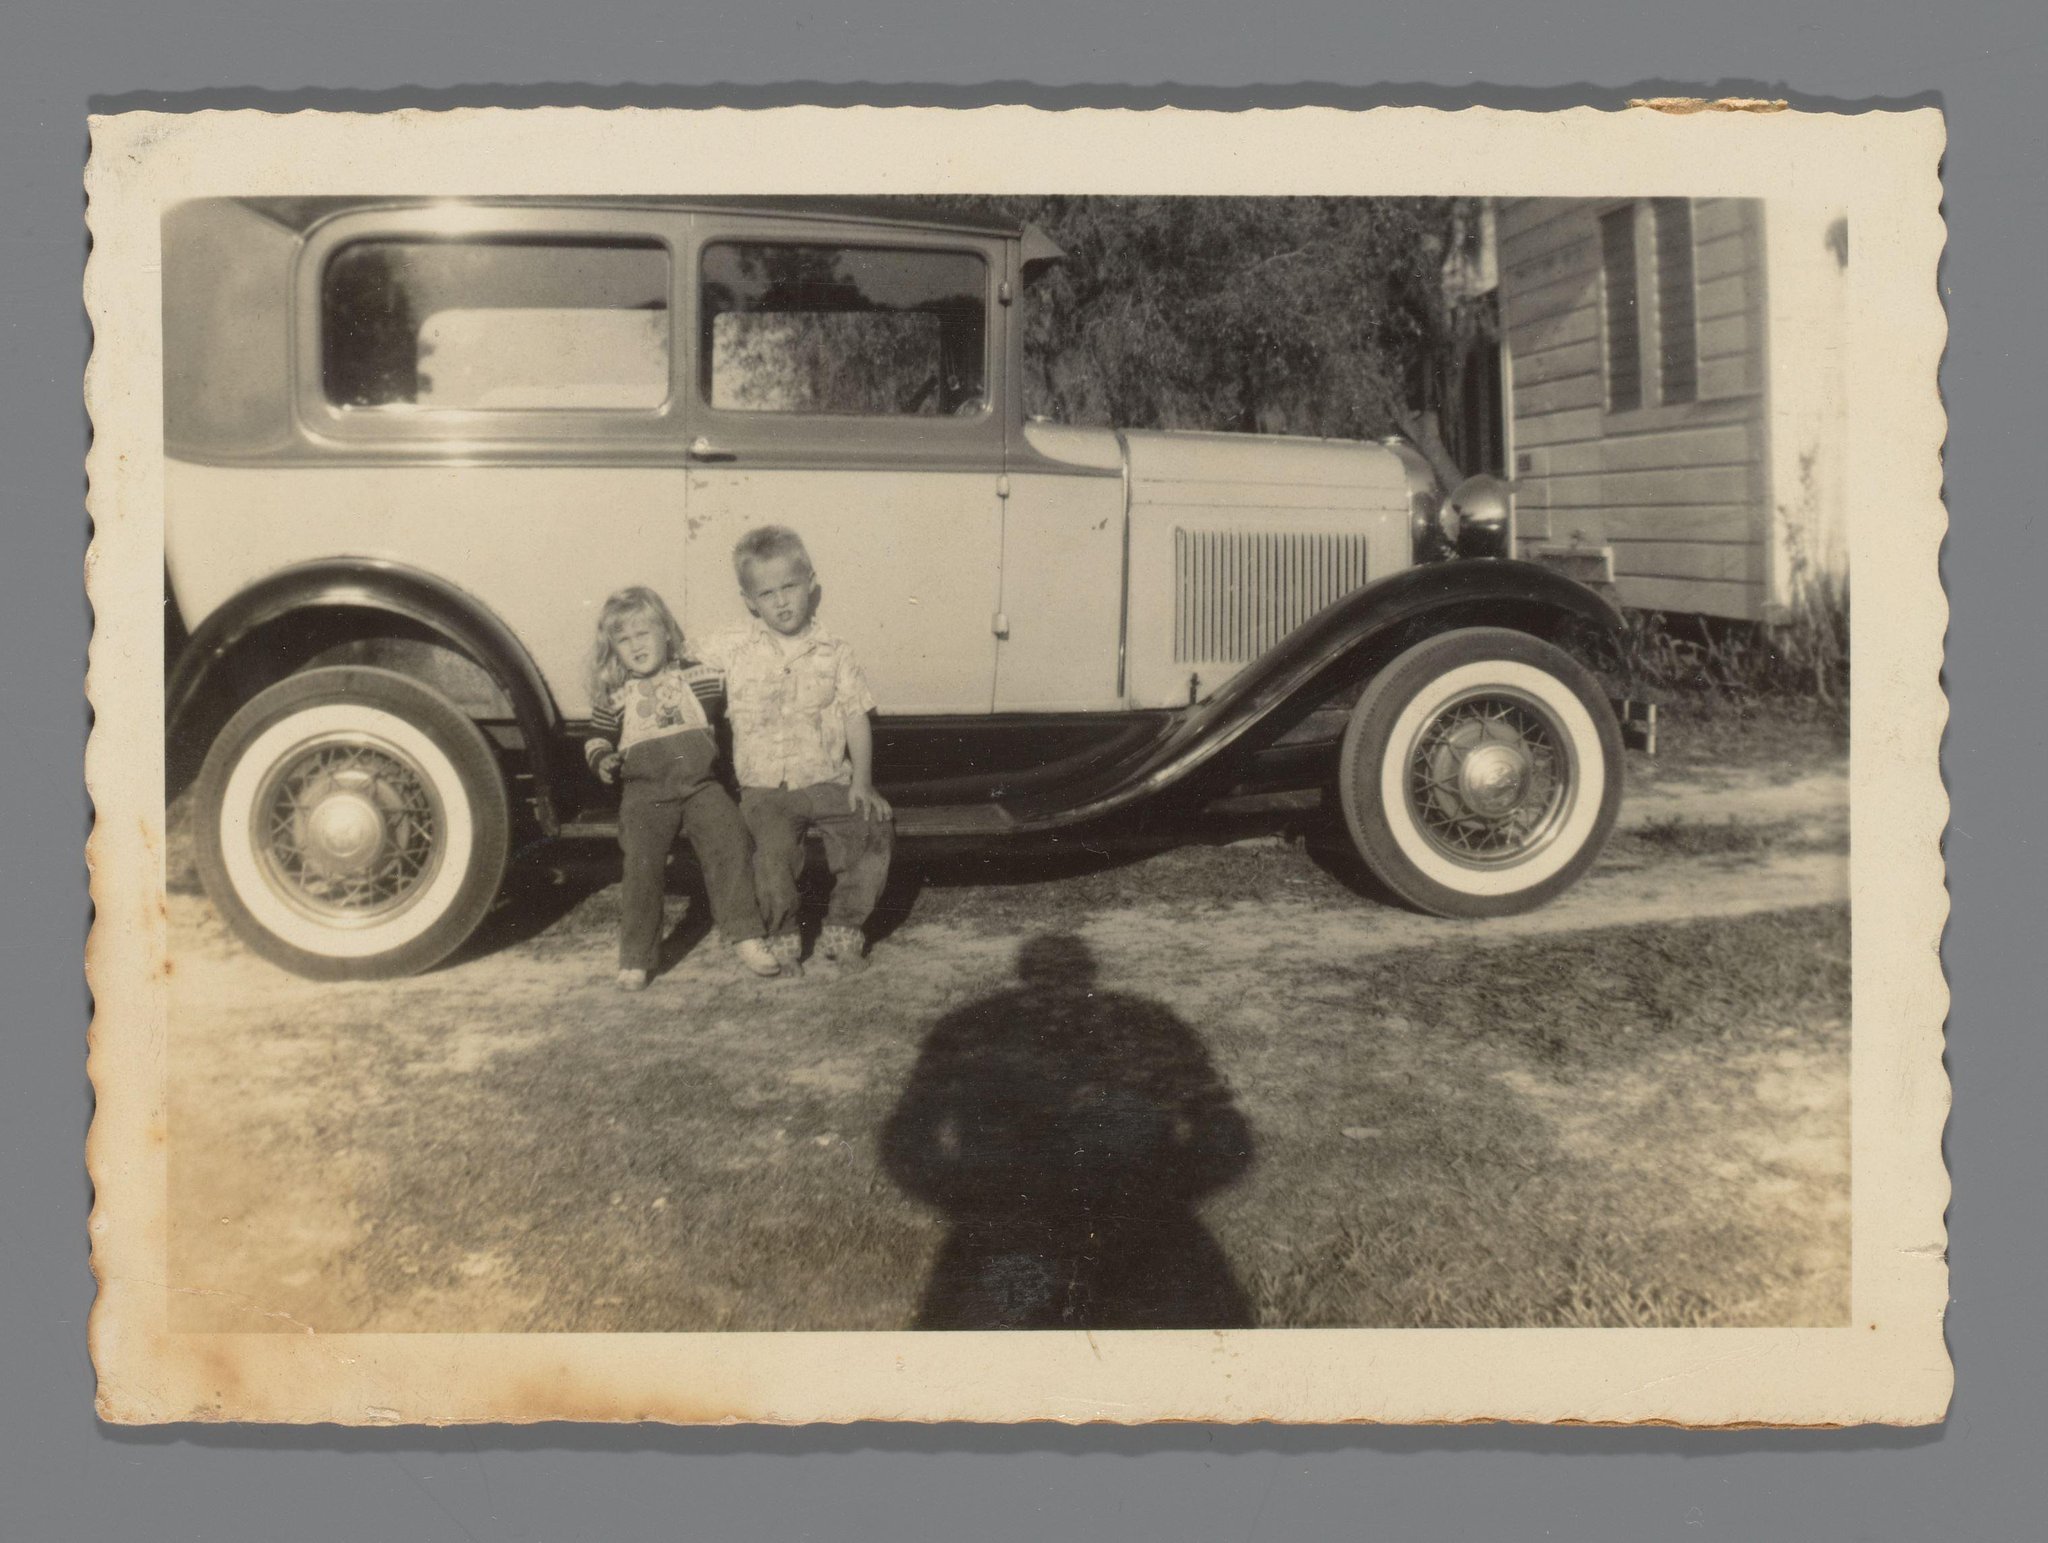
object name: photograph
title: Ford Model A Tudor Sedan met twee kinderen ervoor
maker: Anonymous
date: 1930-1960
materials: paper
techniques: gelatin silver print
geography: united states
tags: child (+ two persons), automobile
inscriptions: inscription: ‘FORD MODEL A’, number: ‘B63299’, inscription: ‘Back in 1905, when there were only 101 moto[...]/ Florida,’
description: Op de voorgrond is de schaduw van de fotograaf te zien.